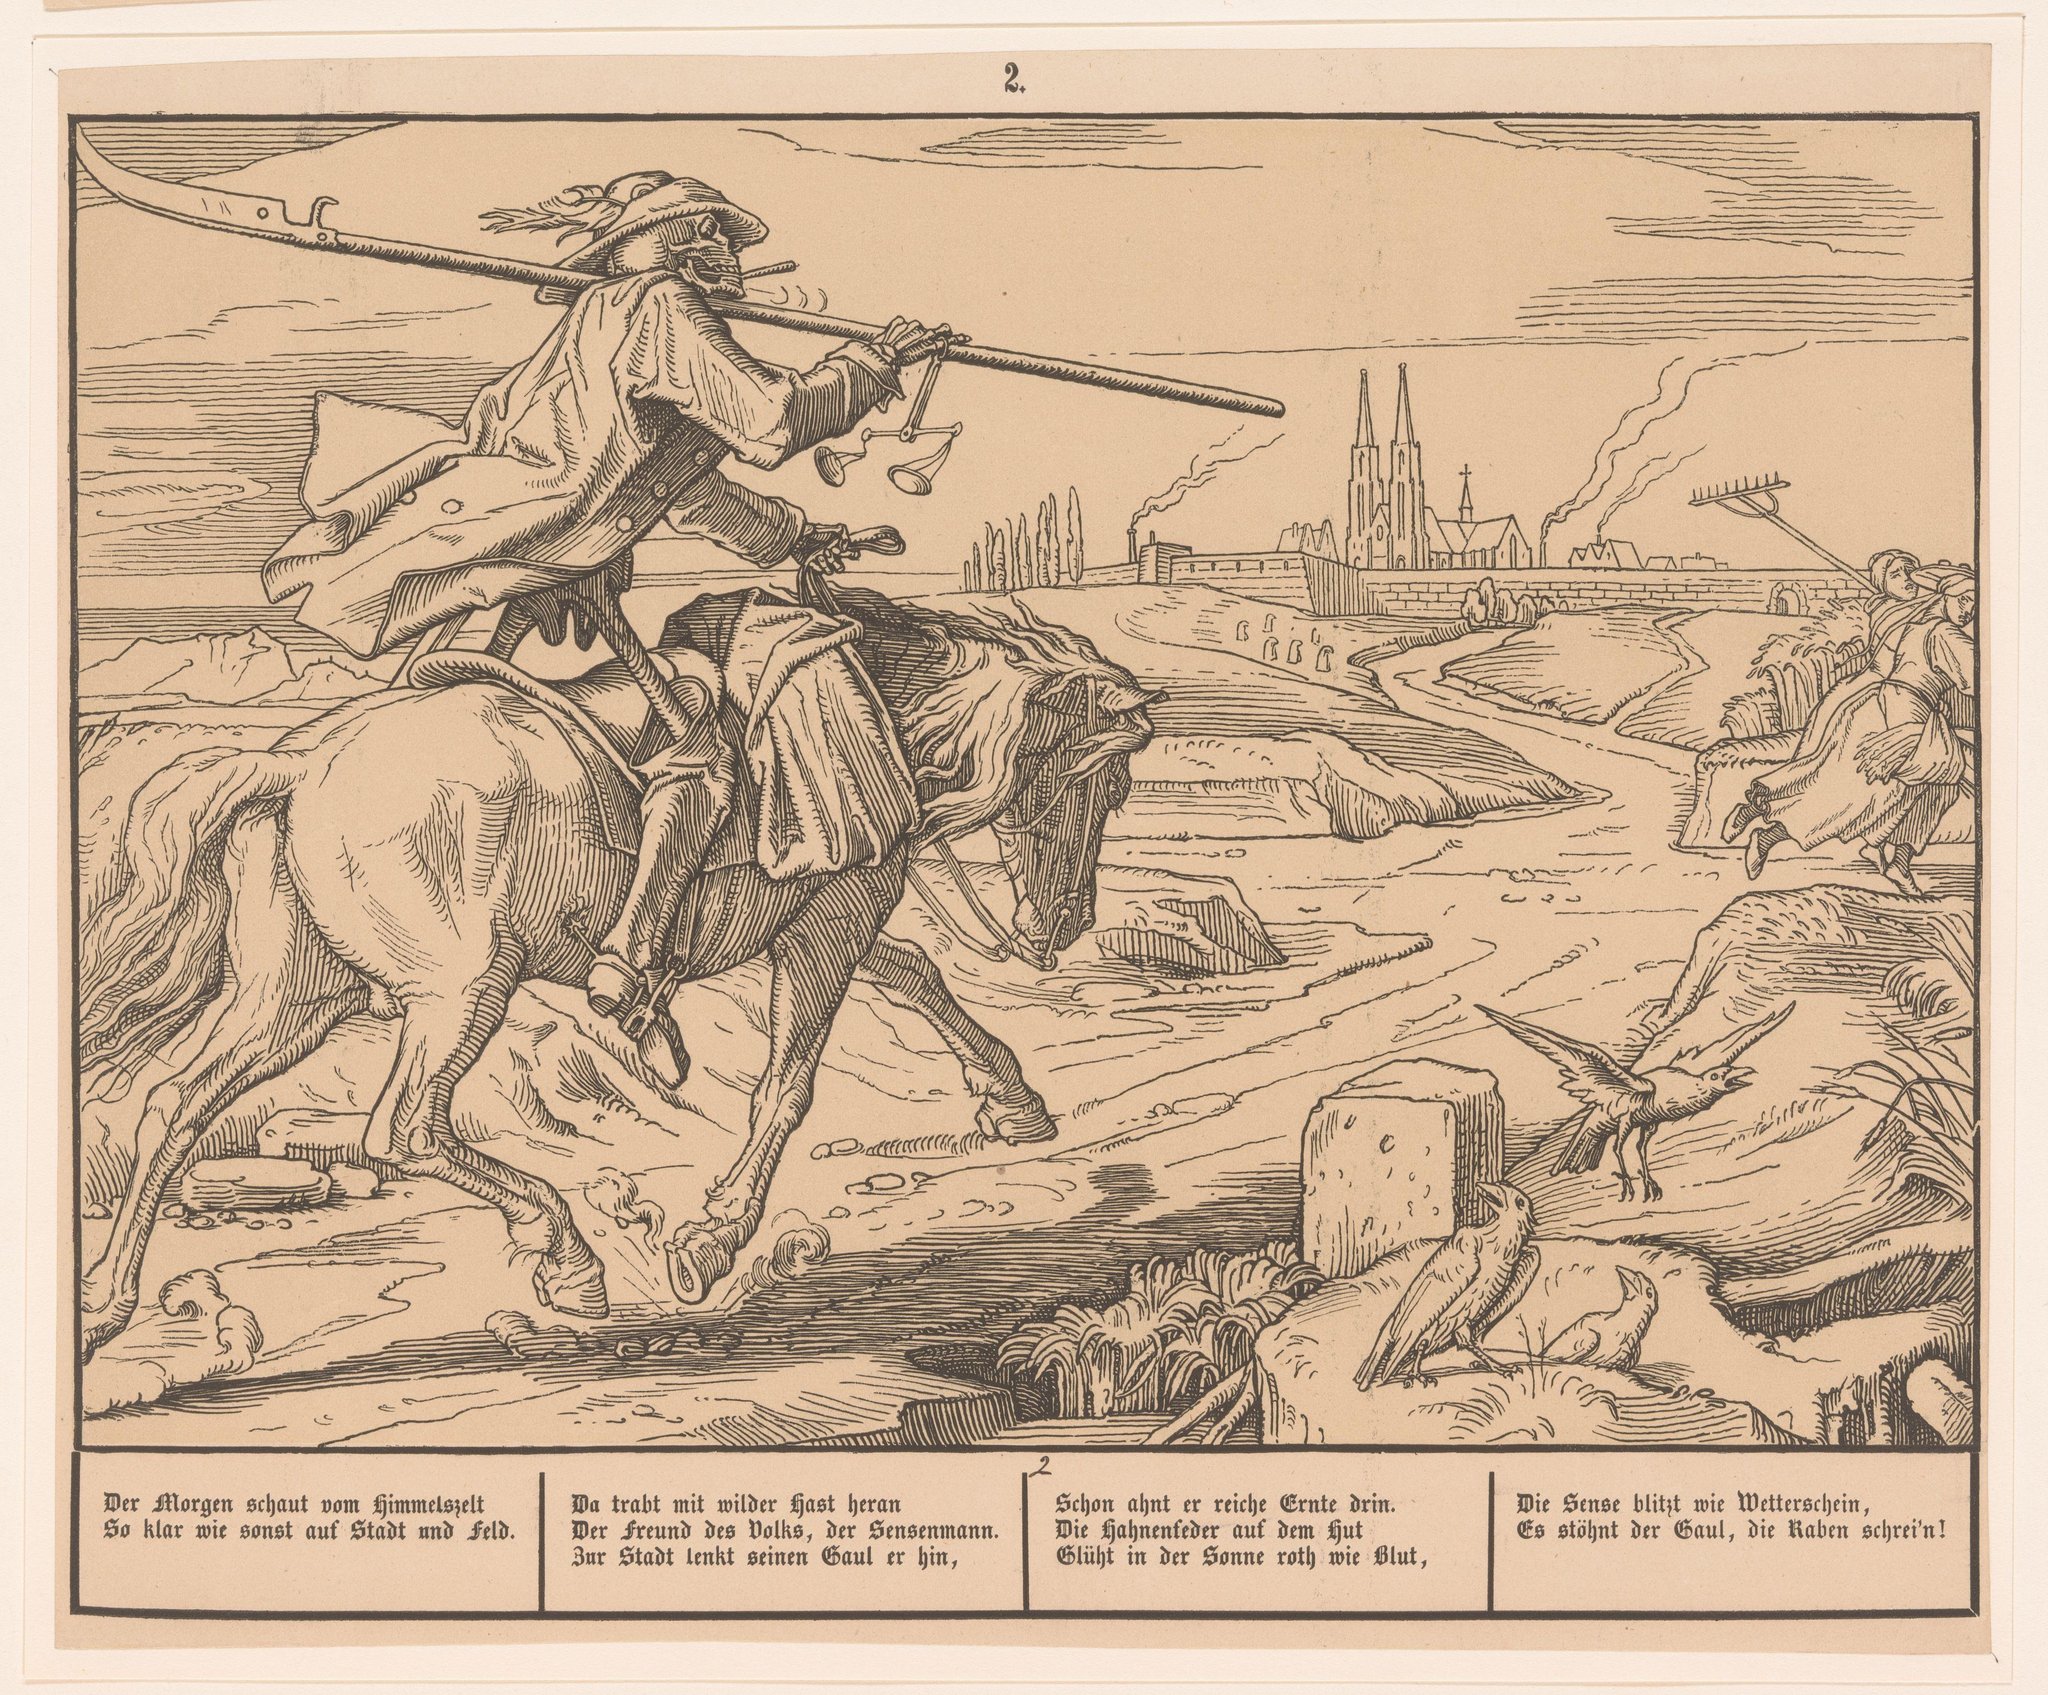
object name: print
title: Nieuwe Dodendans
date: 1848-1849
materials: paper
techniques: woodcut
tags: dance of death; death together with one or more human beings, revolution, revolt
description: Allegorie op de revolutie in de Duitse landen van 1848: "Ein Totentanz aus dem Jahre 1848", Volksuitgave van Augustus.